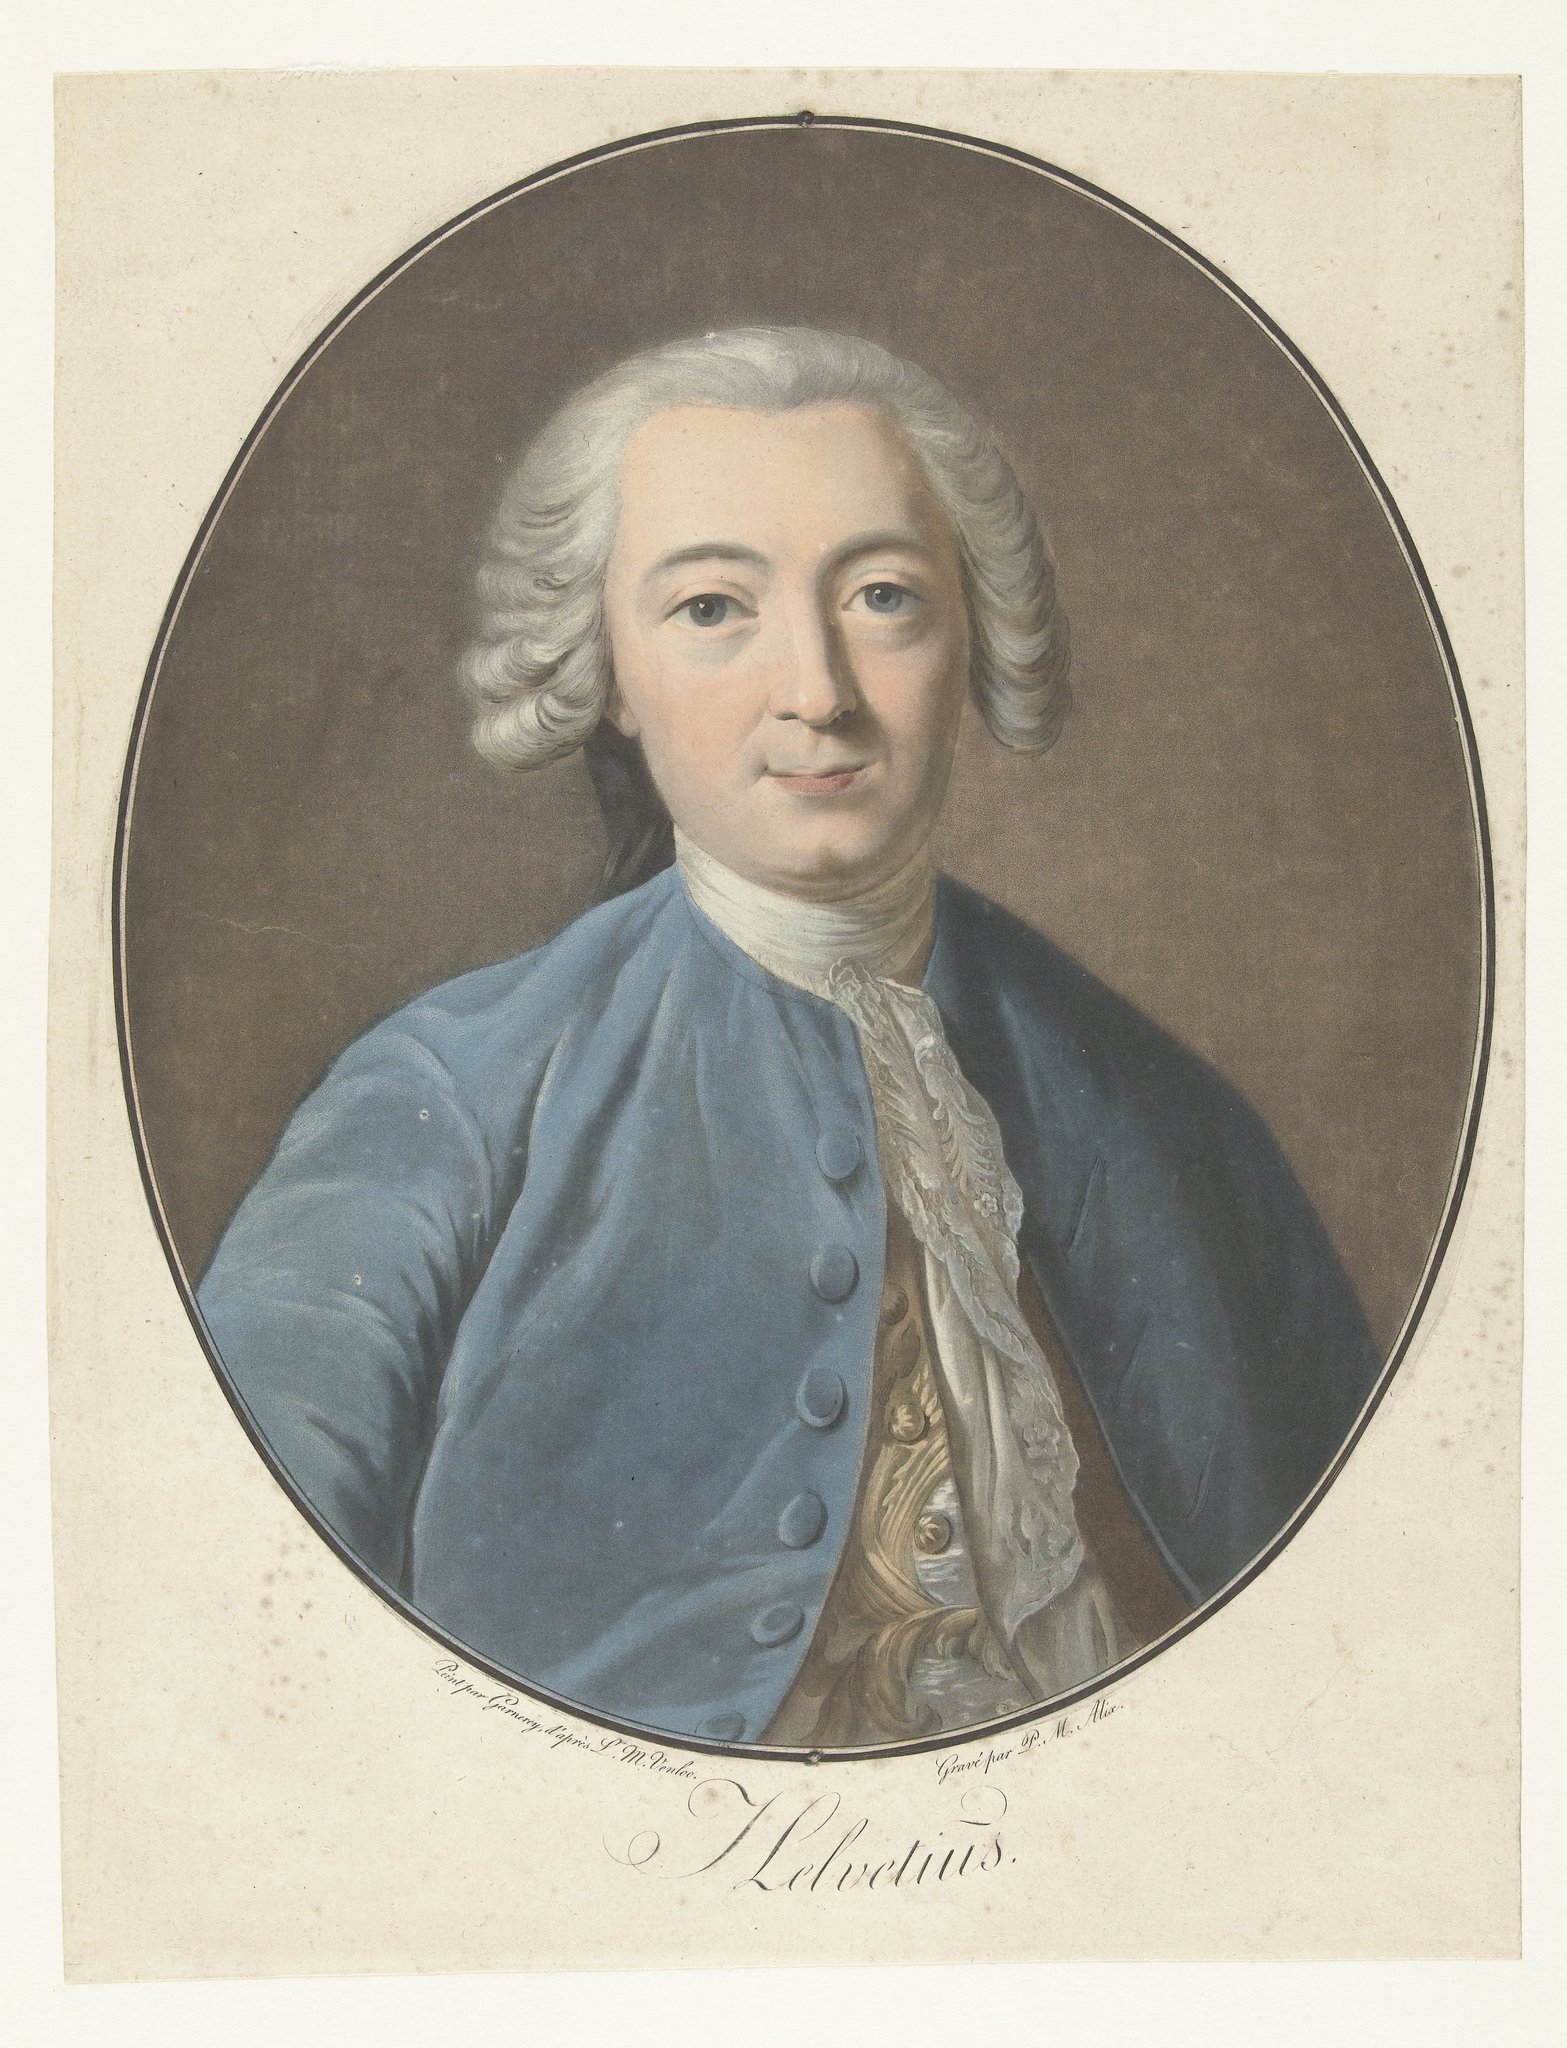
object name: print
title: Portret van Claude Adrien Helvétius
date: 1793-1795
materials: paper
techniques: color aquatint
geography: france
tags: claude-adrien helvétius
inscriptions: collector's mark: Lugt 2228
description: Portret van de Franse filosoof Claude Adrien Helvétius, in een ovaal.